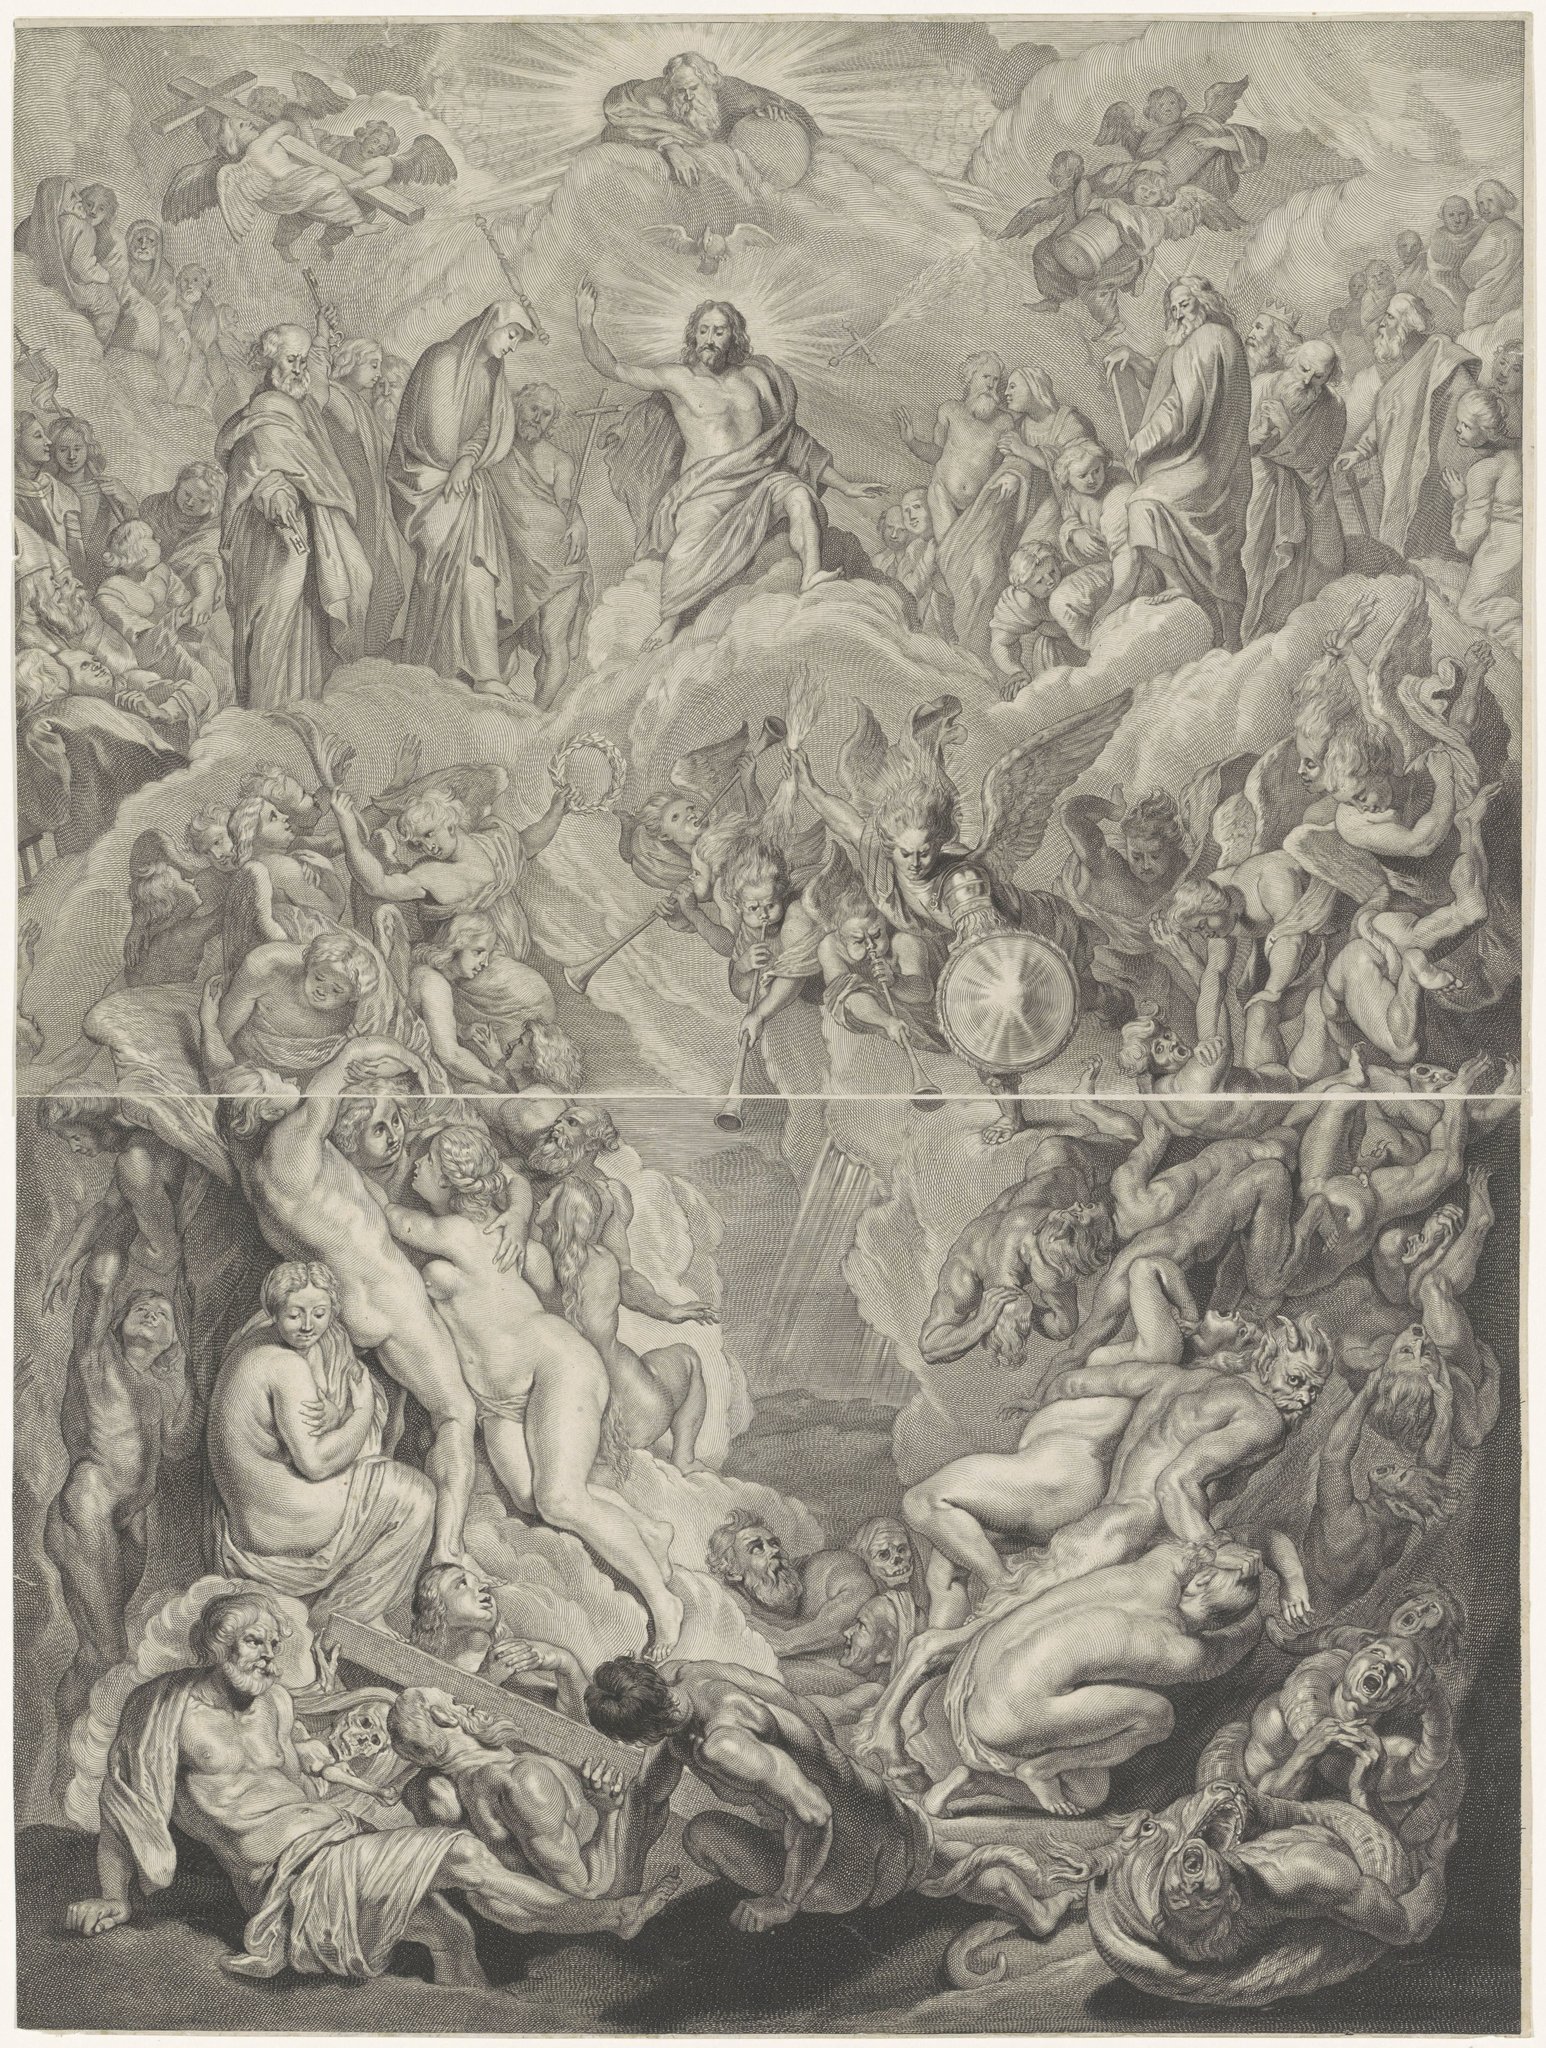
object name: print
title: Laatste Oordeel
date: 1638-1658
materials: paper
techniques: engraving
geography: haarlem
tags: last judgement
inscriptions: collector's mark: Lugt 10, collector's mark: Lugt 11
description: Christus zit tronend als rechter op een wolk in de hemel bij het Laatste oordeel. Hij maakt een spreekgebaar en wordt omringd door engelen, koningen, kerkvaders en zijn apostelen. Boven hem vliegt de duif van de Heilige Geest en ligt God met de wereldbol op een wolk. Onder de engelen worden vrouwen en mannen door allerlei duivels en beesten aangevallen en meegevoerd naar de hel. Voorstelling bestaande uit twee delen.